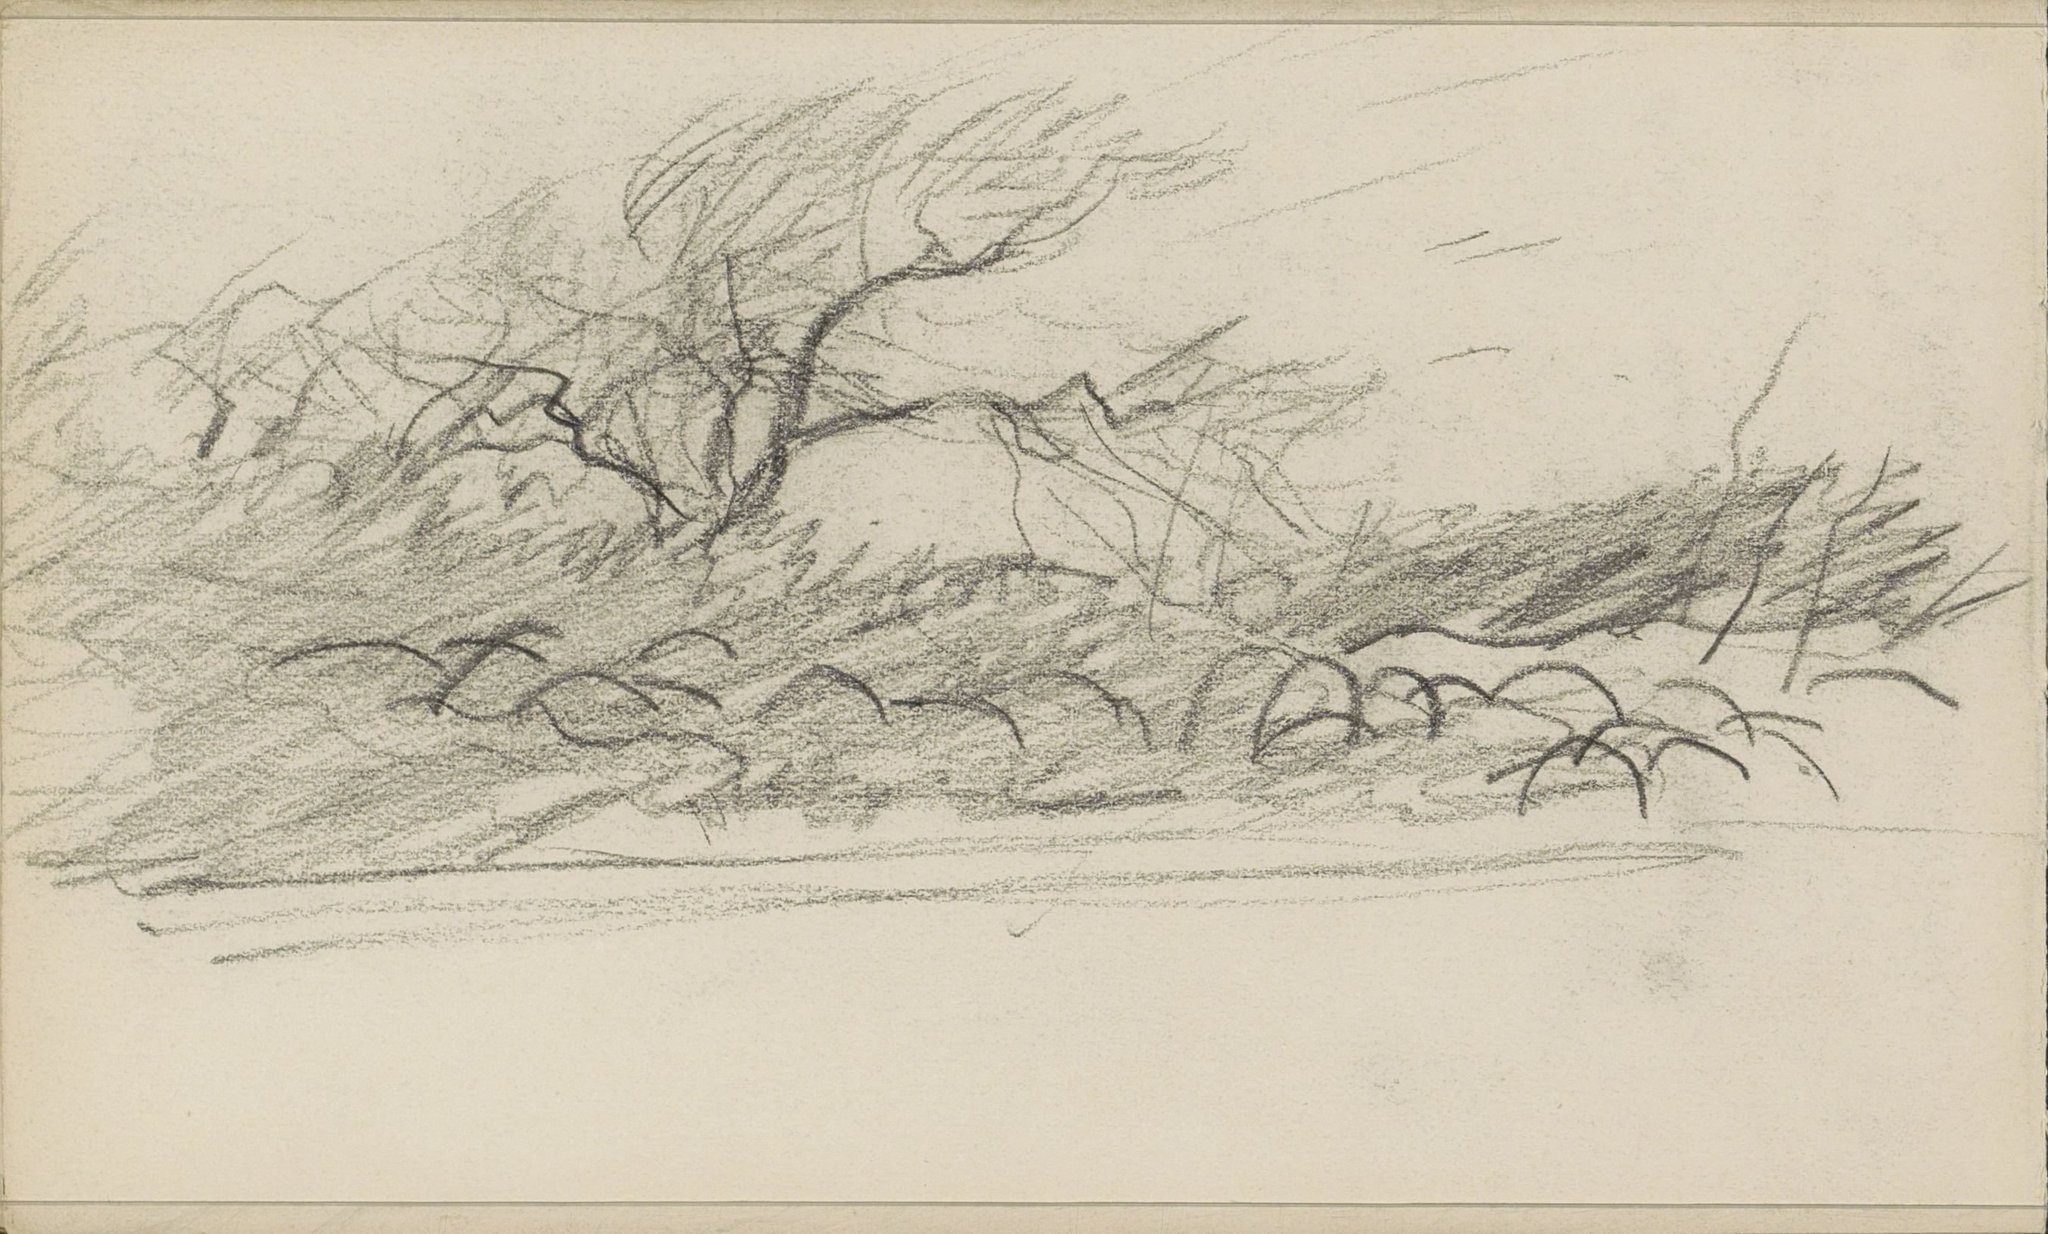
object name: sketchbook leaf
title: Landschap met bomen en een kudde schapen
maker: anton mauve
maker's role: draughtsman, painter, print maker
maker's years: 1838-1888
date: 1848-1888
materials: chalk, paper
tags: landscapes, herd, flock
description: Blad 5 verso uit een schetsboek met 33 bladen.